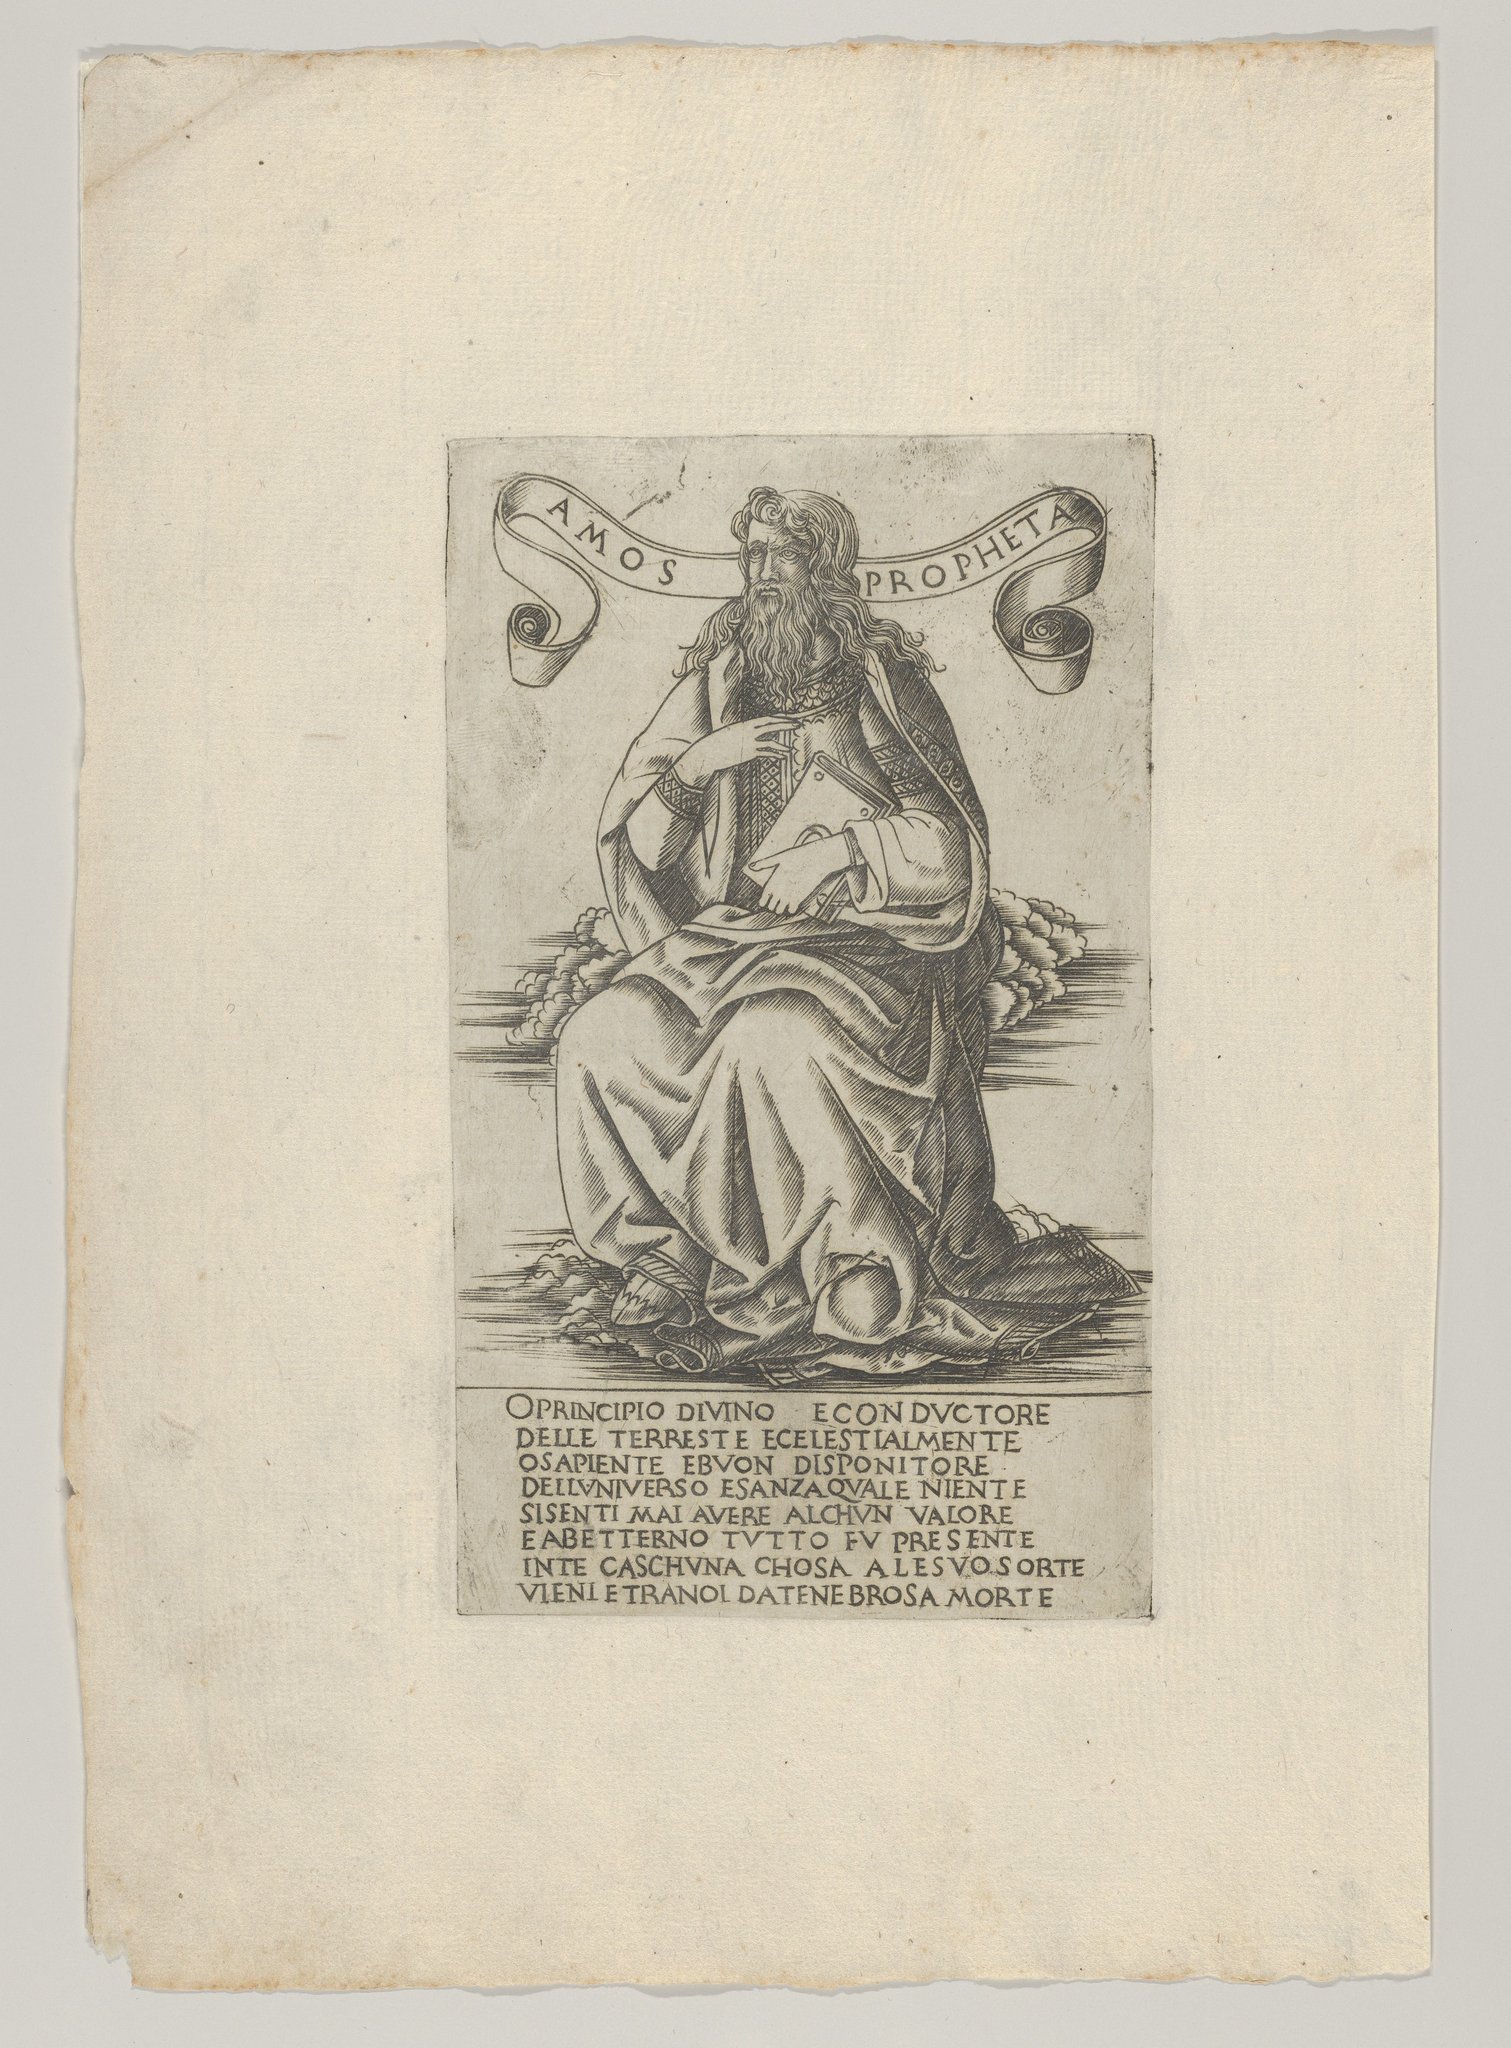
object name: print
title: The Prophet Amos, from Prophets and Sibyls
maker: francesco rosselli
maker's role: artist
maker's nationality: italian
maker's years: 1448-1527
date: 1480-1490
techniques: engraving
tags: men,portraits